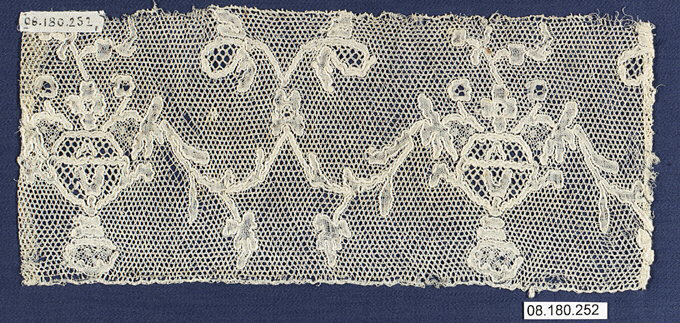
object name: fragment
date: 1701-1800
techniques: lace